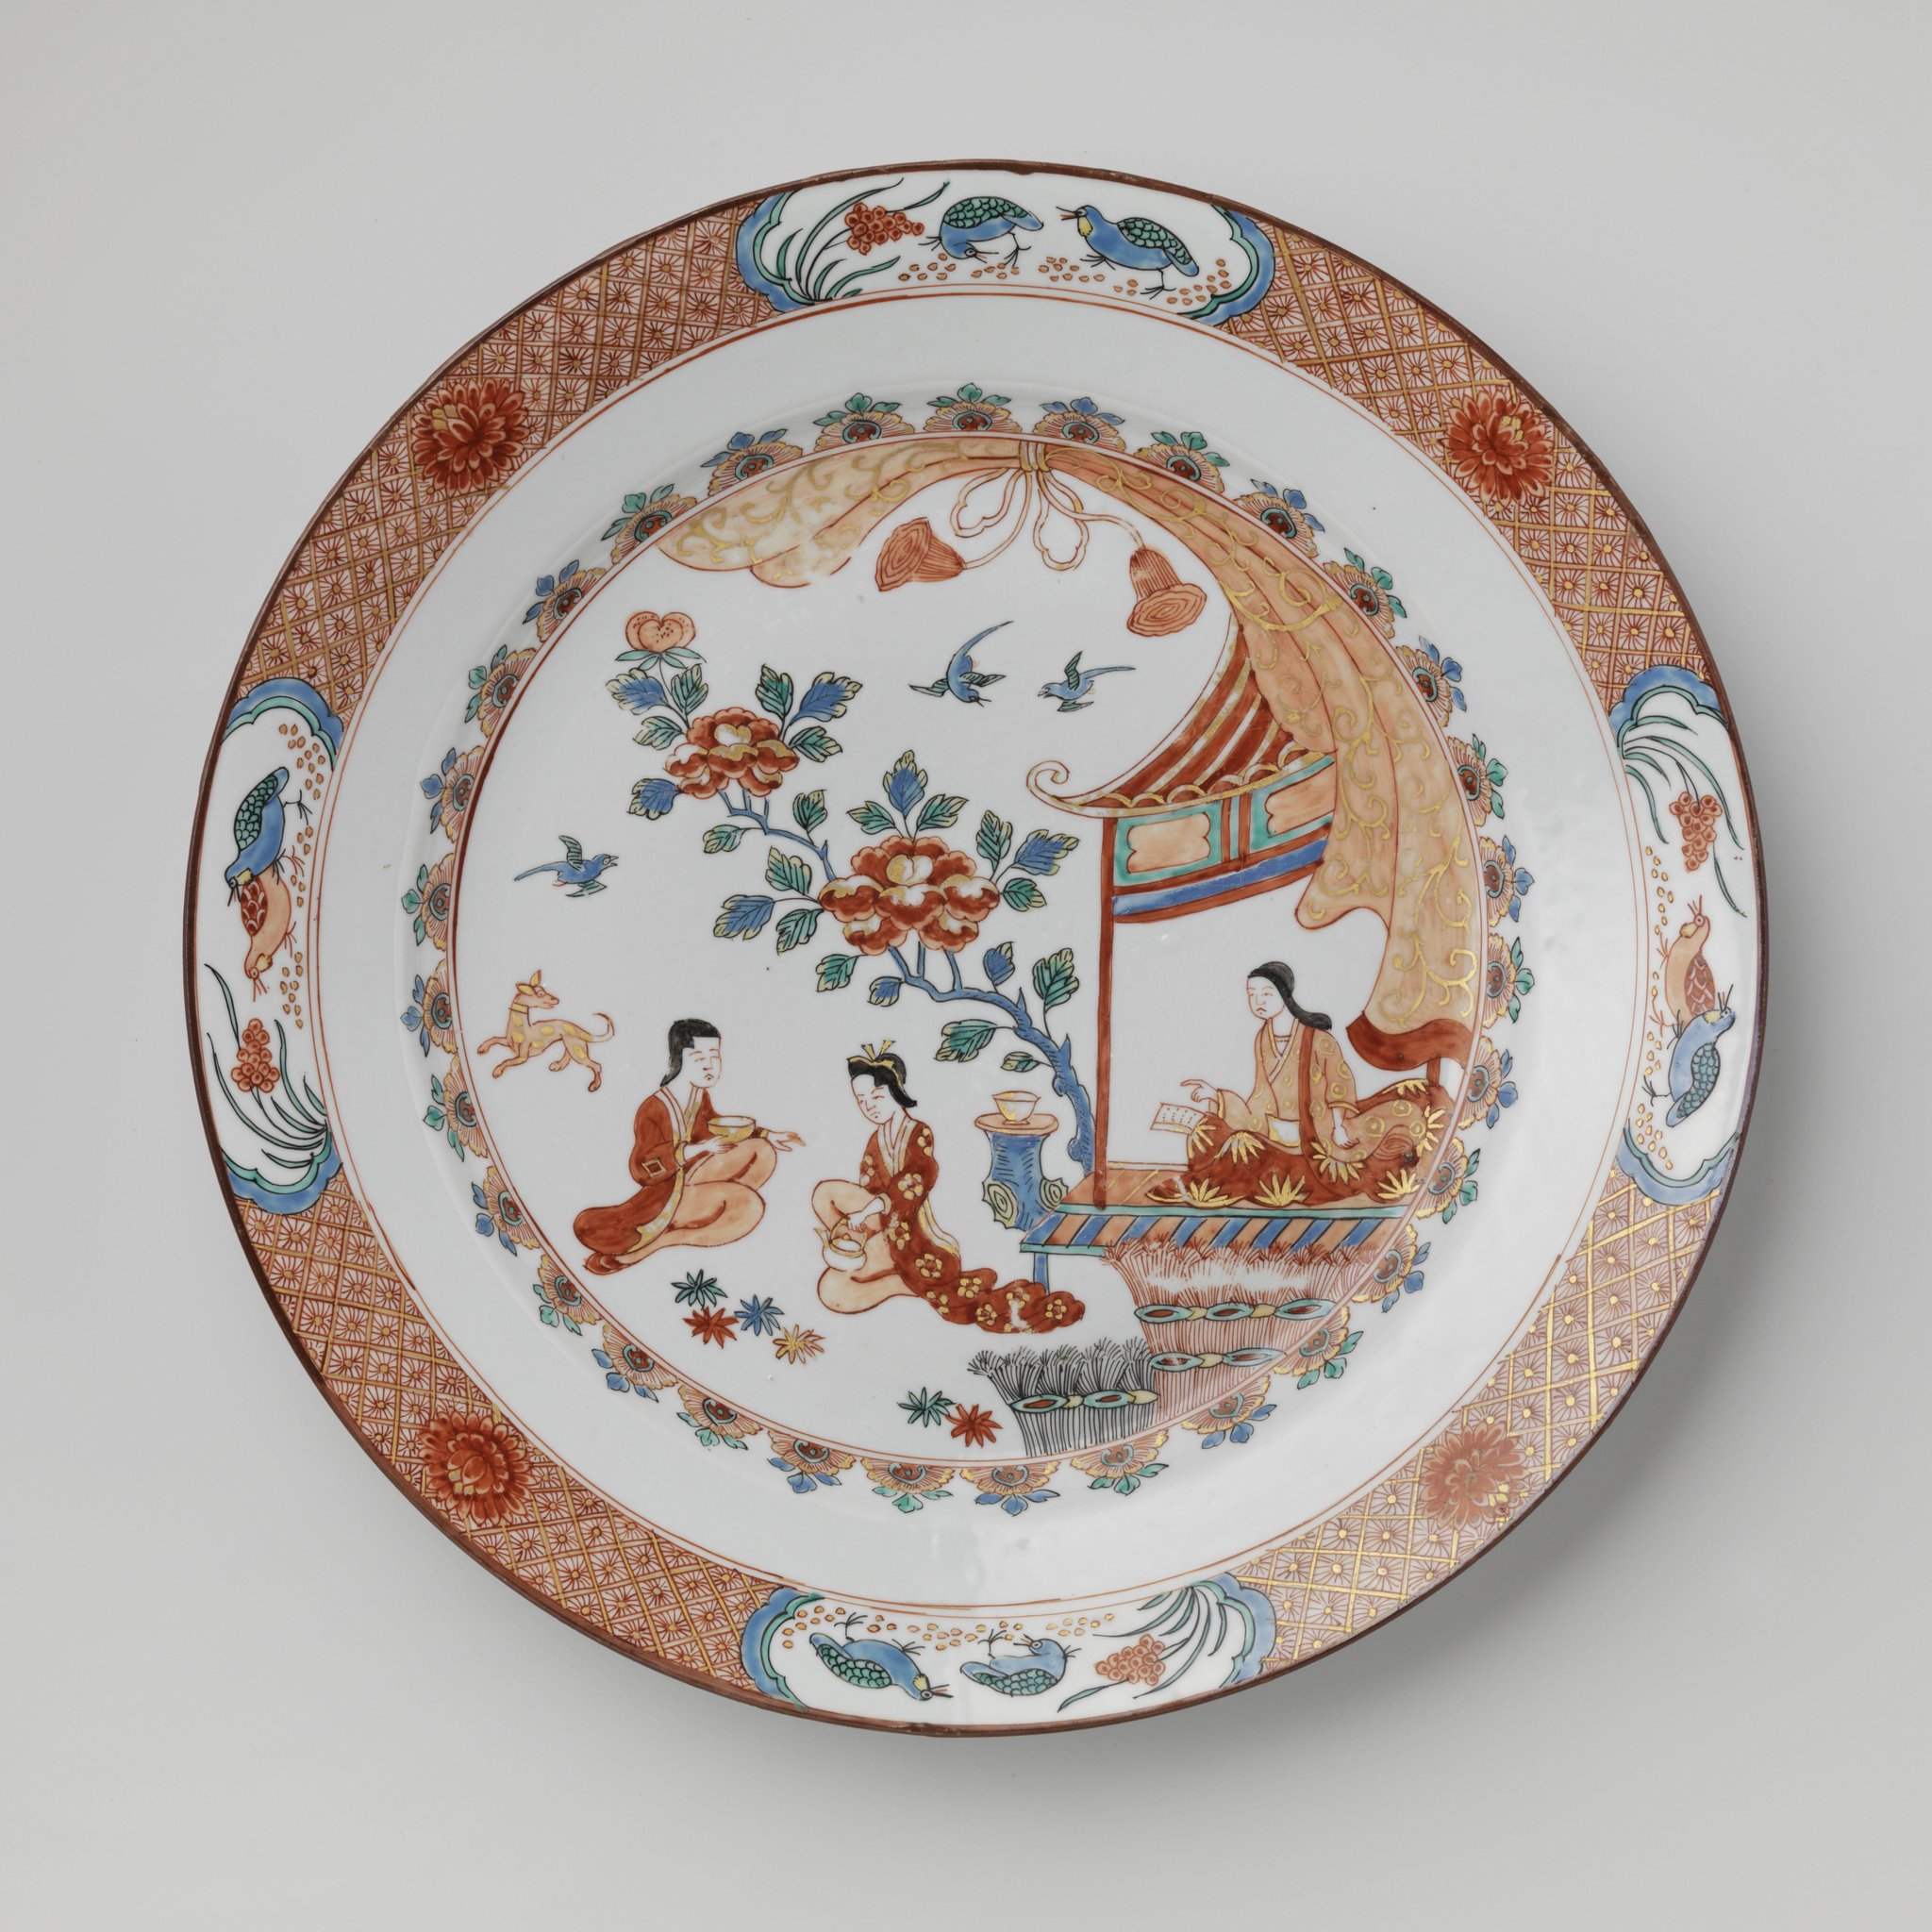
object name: platter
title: Dish with three women near a pavilion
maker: Anonymous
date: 1700-1724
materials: glaze, gold, paint, porcelain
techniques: firing, gilding, turning, vitrification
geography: china